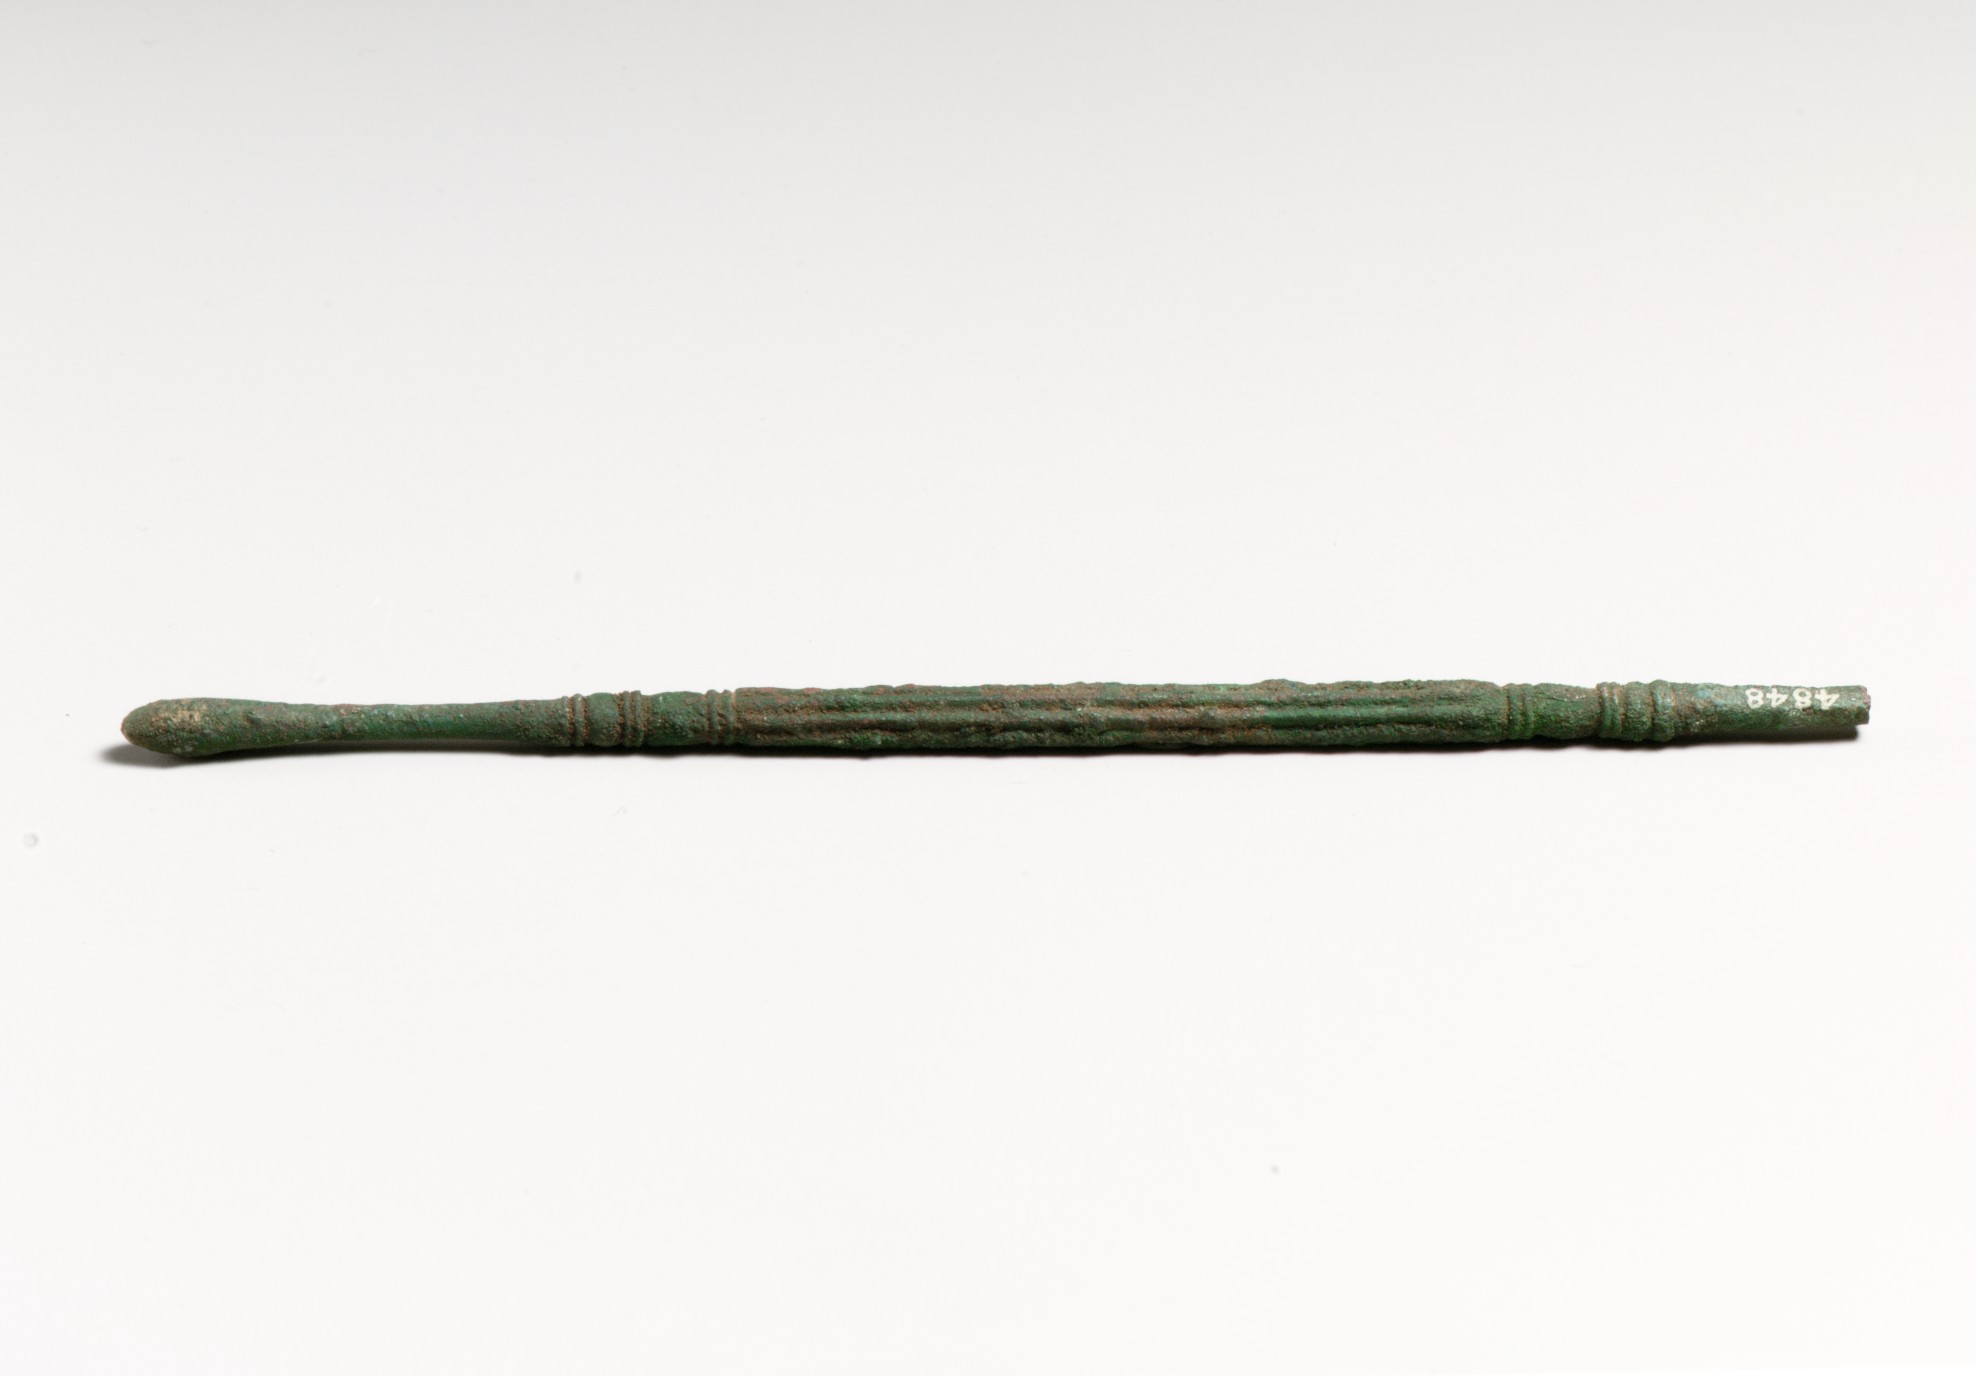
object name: probe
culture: cypriot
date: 3900 BCE-100 CE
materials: bronze